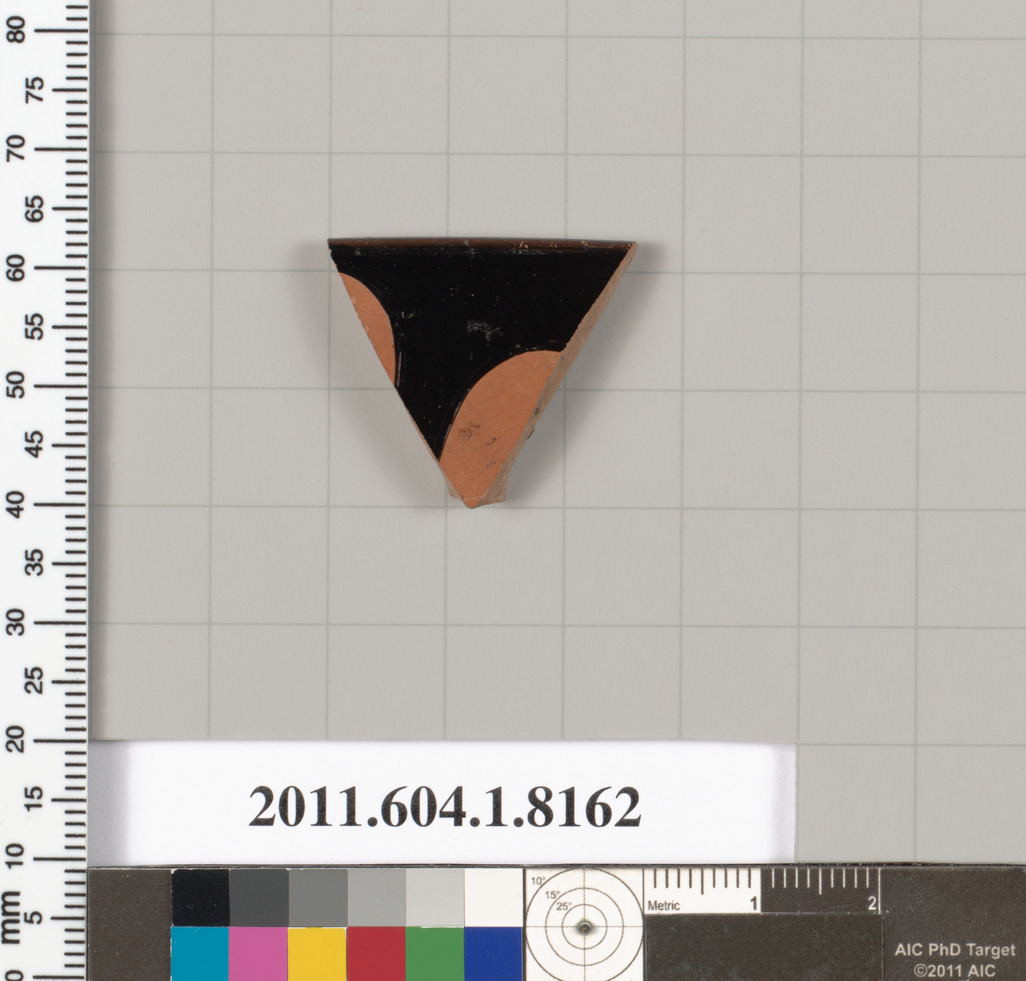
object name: kylix fragment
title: Terracotta rim fragment of a kylix (drinking cup)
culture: greek, attic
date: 520-510 BCE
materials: terracotta